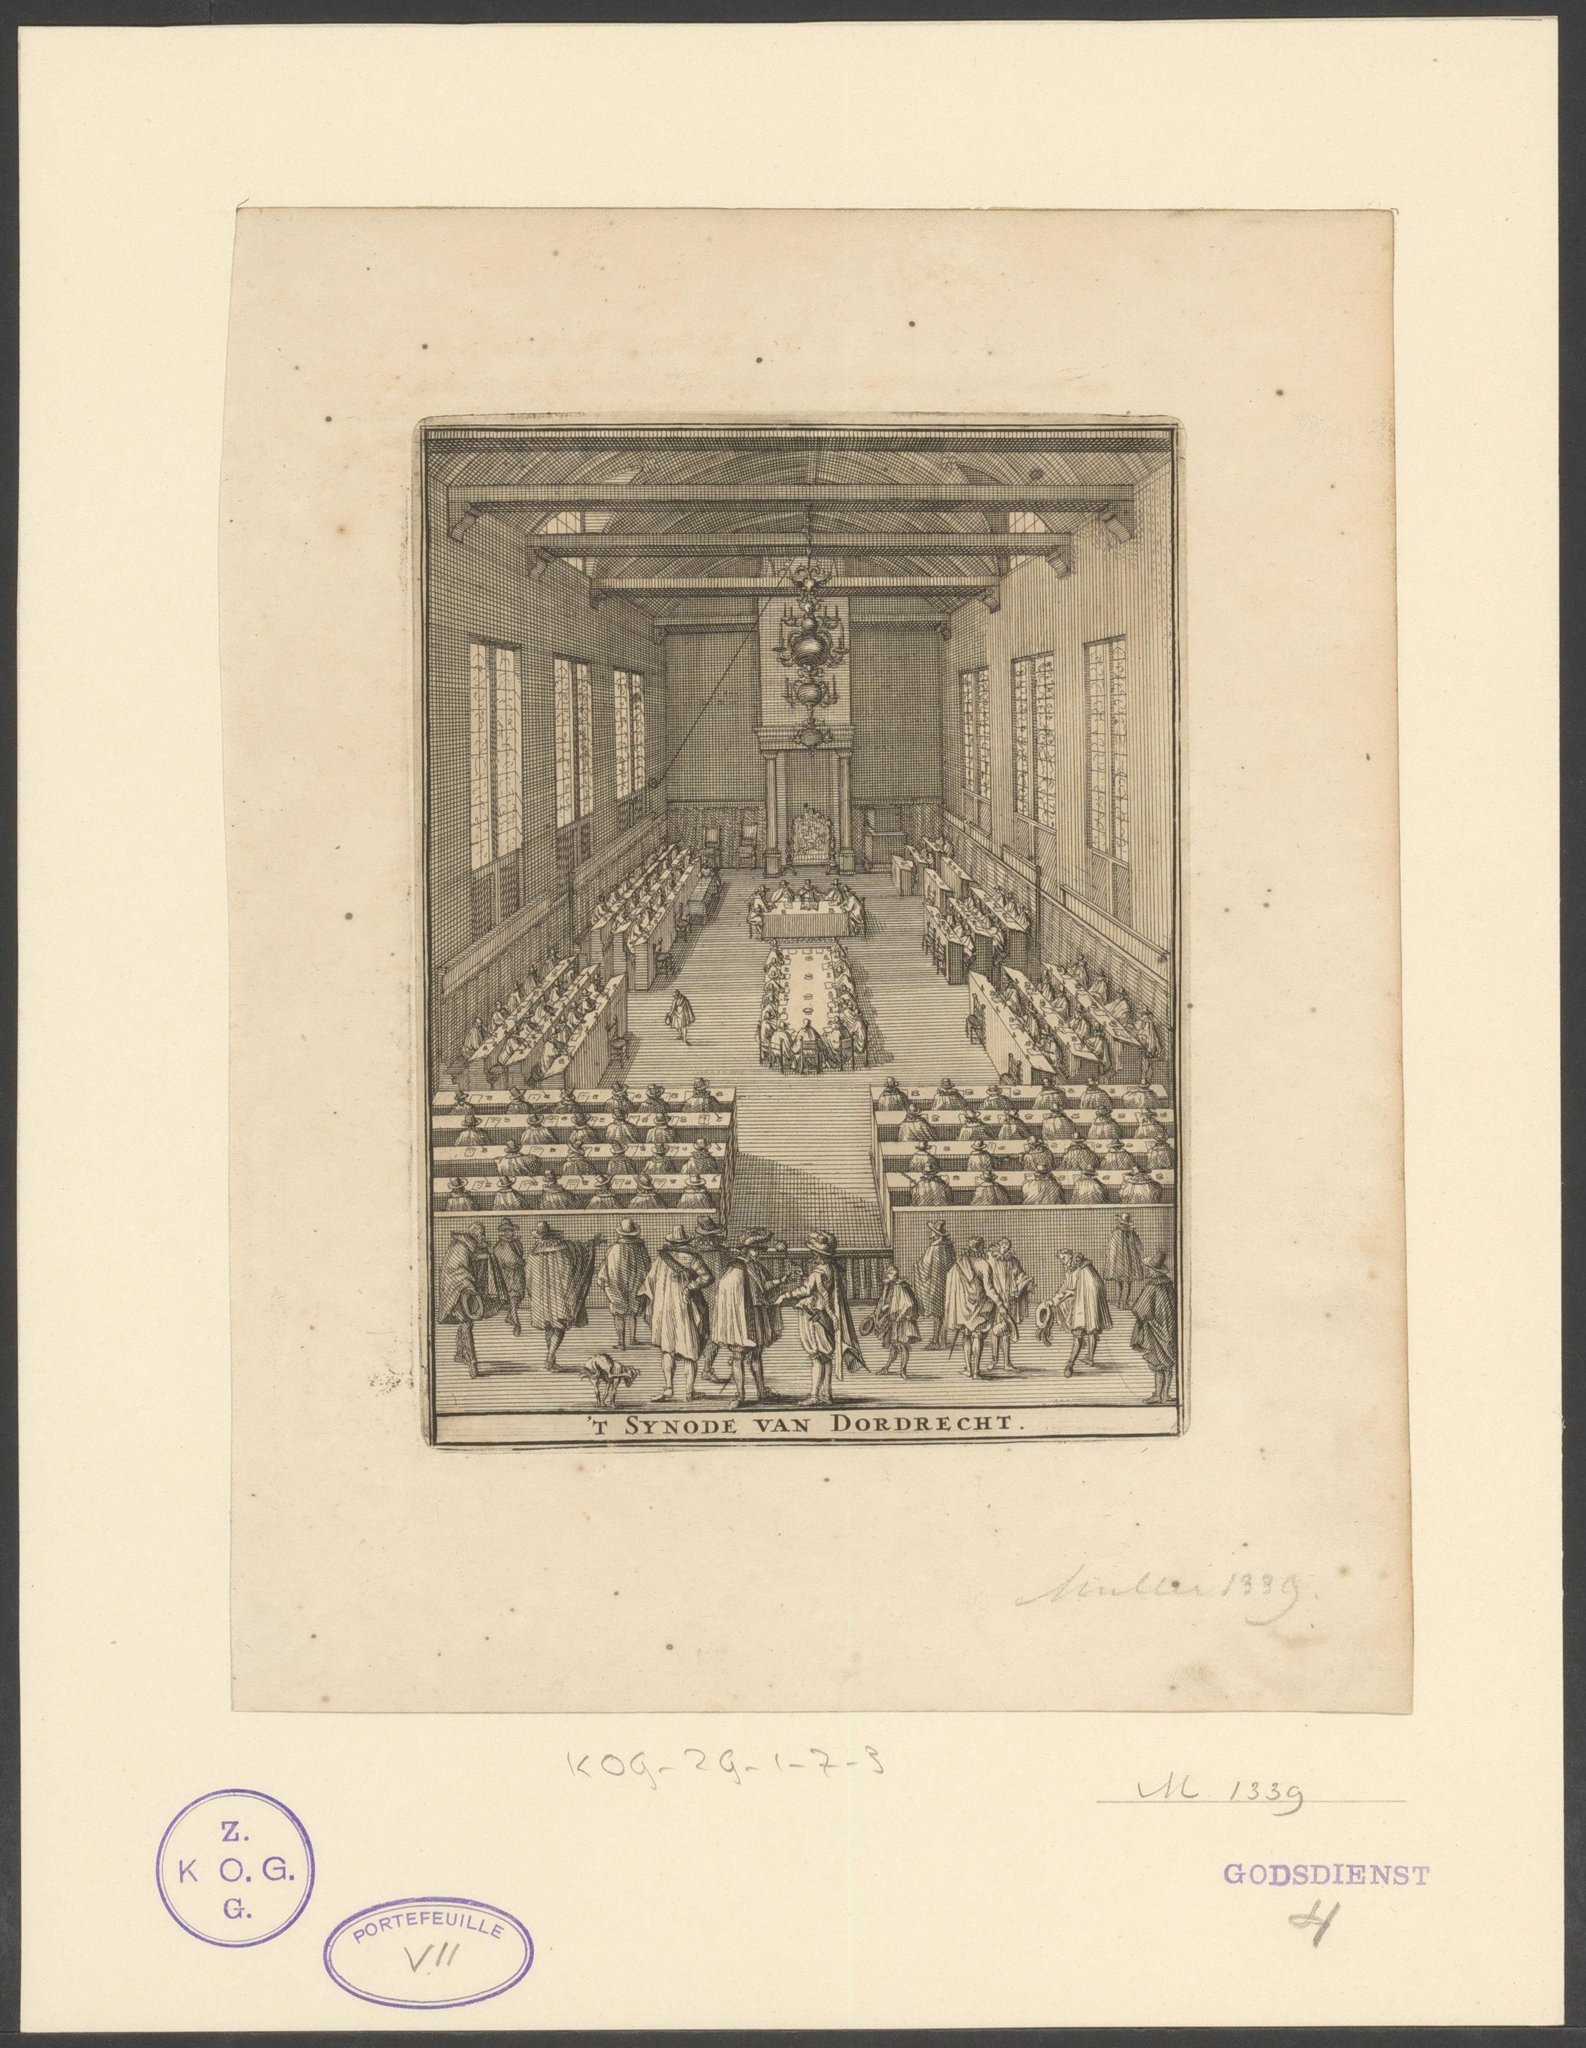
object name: print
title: 'T Synode van Dordrecht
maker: Anonymous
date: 1619-1699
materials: paper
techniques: etching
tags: organizations, assemblies, etc. in protestant churches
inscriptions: collector's mark: Lugt 1641, stamp, stamp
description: De opening van de nationale synode te Dordrecht op 13 november 1618. Gezicht in de grote zaal van de Kloveniersdoelen met alle aanwezigen en toeschouwers. Onderwerpsrubrieken binnen de Atlas Zeden en Gewoonten: Godsdienst, Ned. Hervormden, (Oudtijds Gereformeerden), Synode van Dordrecht.